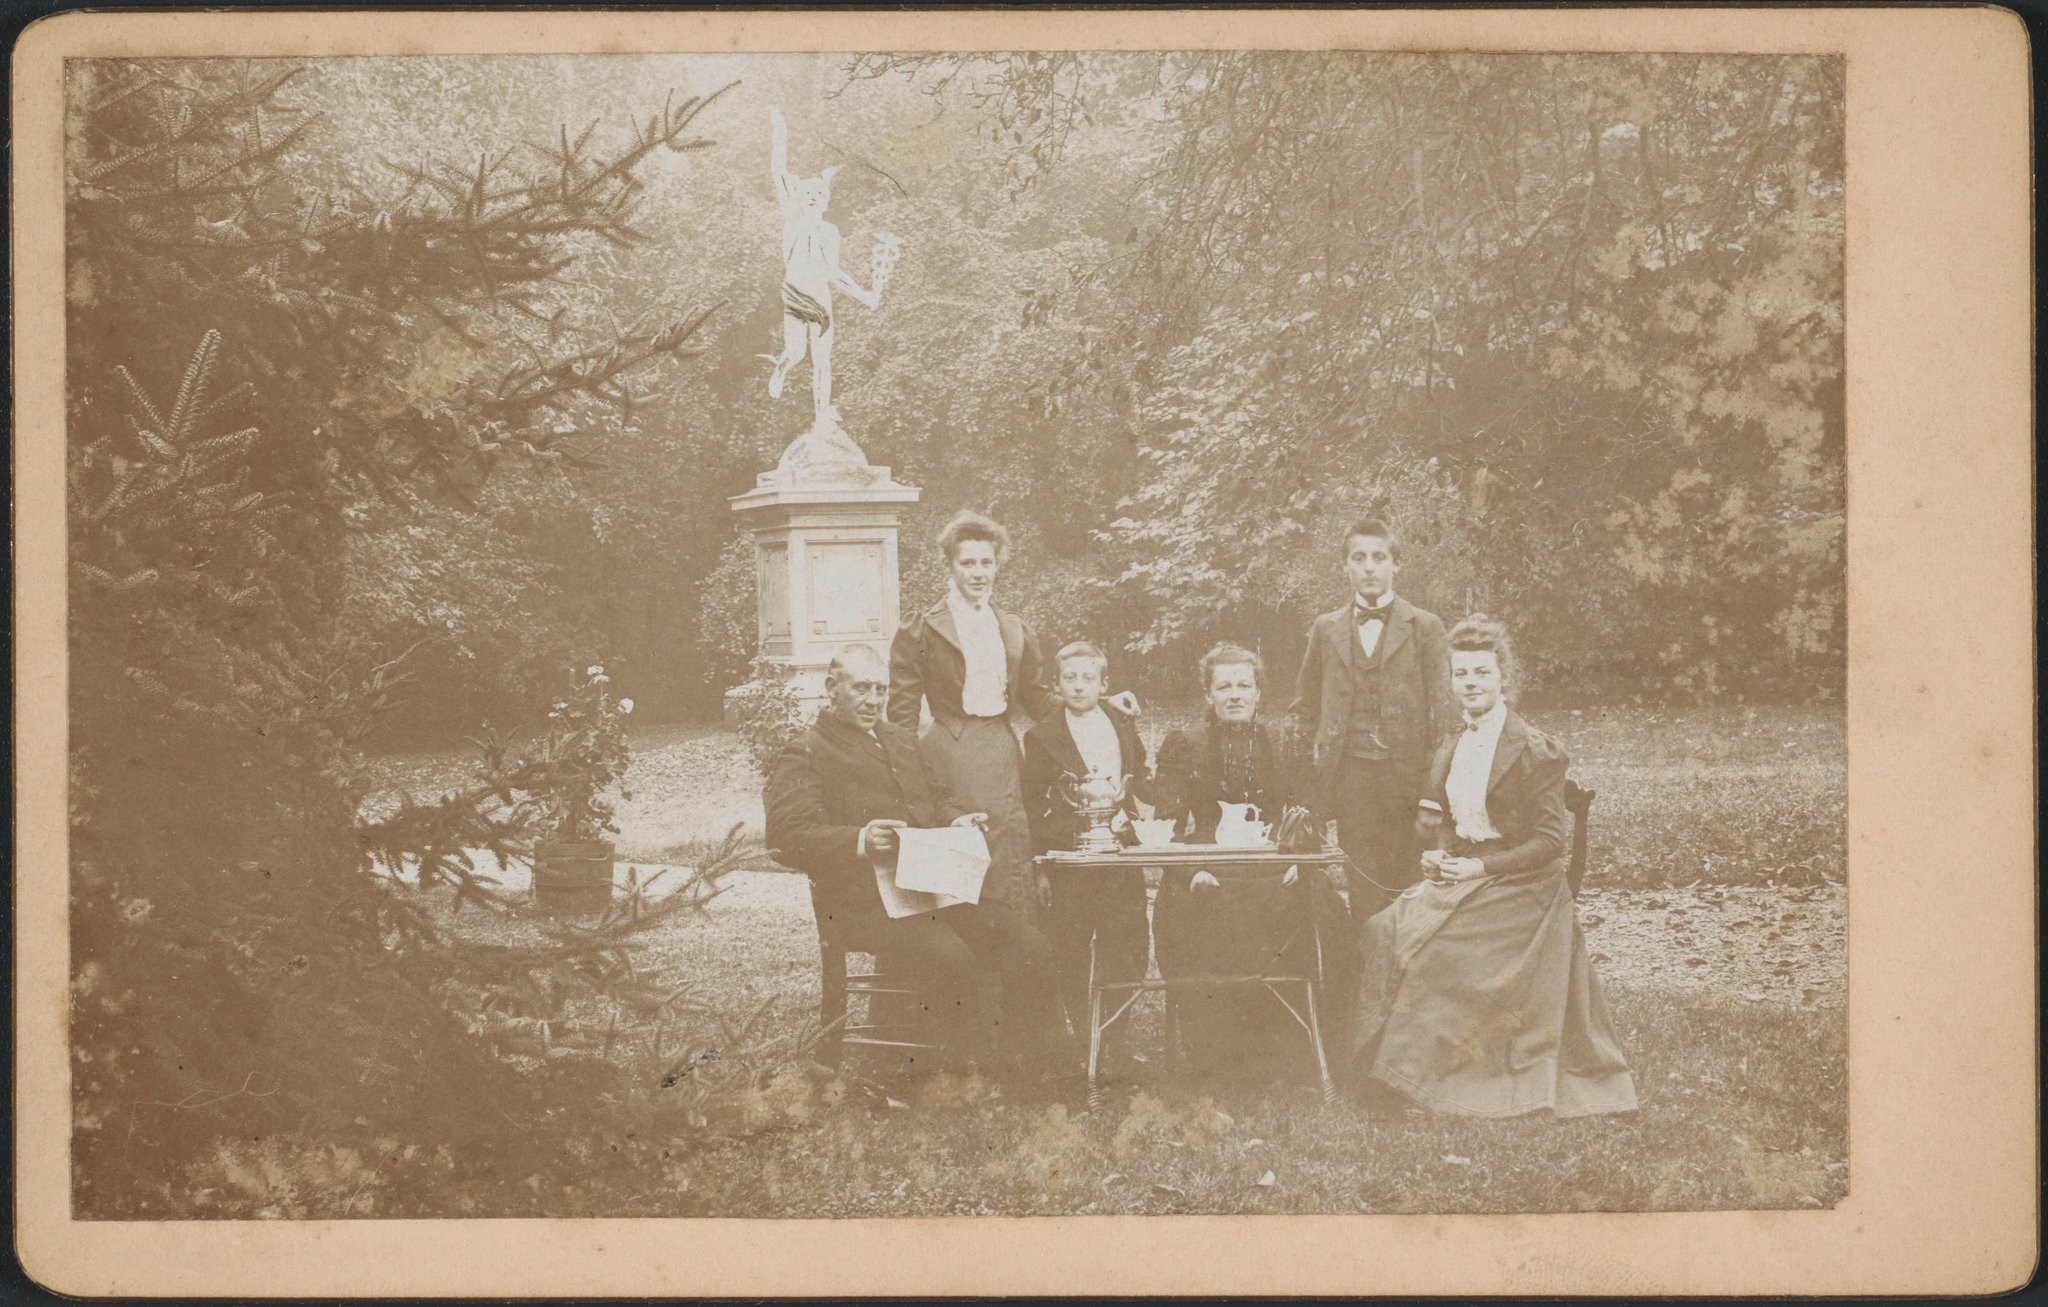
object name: photograph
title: Gezelschap in een park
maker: Anonymous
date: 1899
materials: cardboard, photographic support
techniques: collodion silver print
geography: loenen aan de vecht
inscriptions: annotation: ‘Loenen a/d Vecht // 22 Oct. 1899’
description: Een man, drie vrouwen en twee jongens, zittend en staand rond een tafel met theeservies.